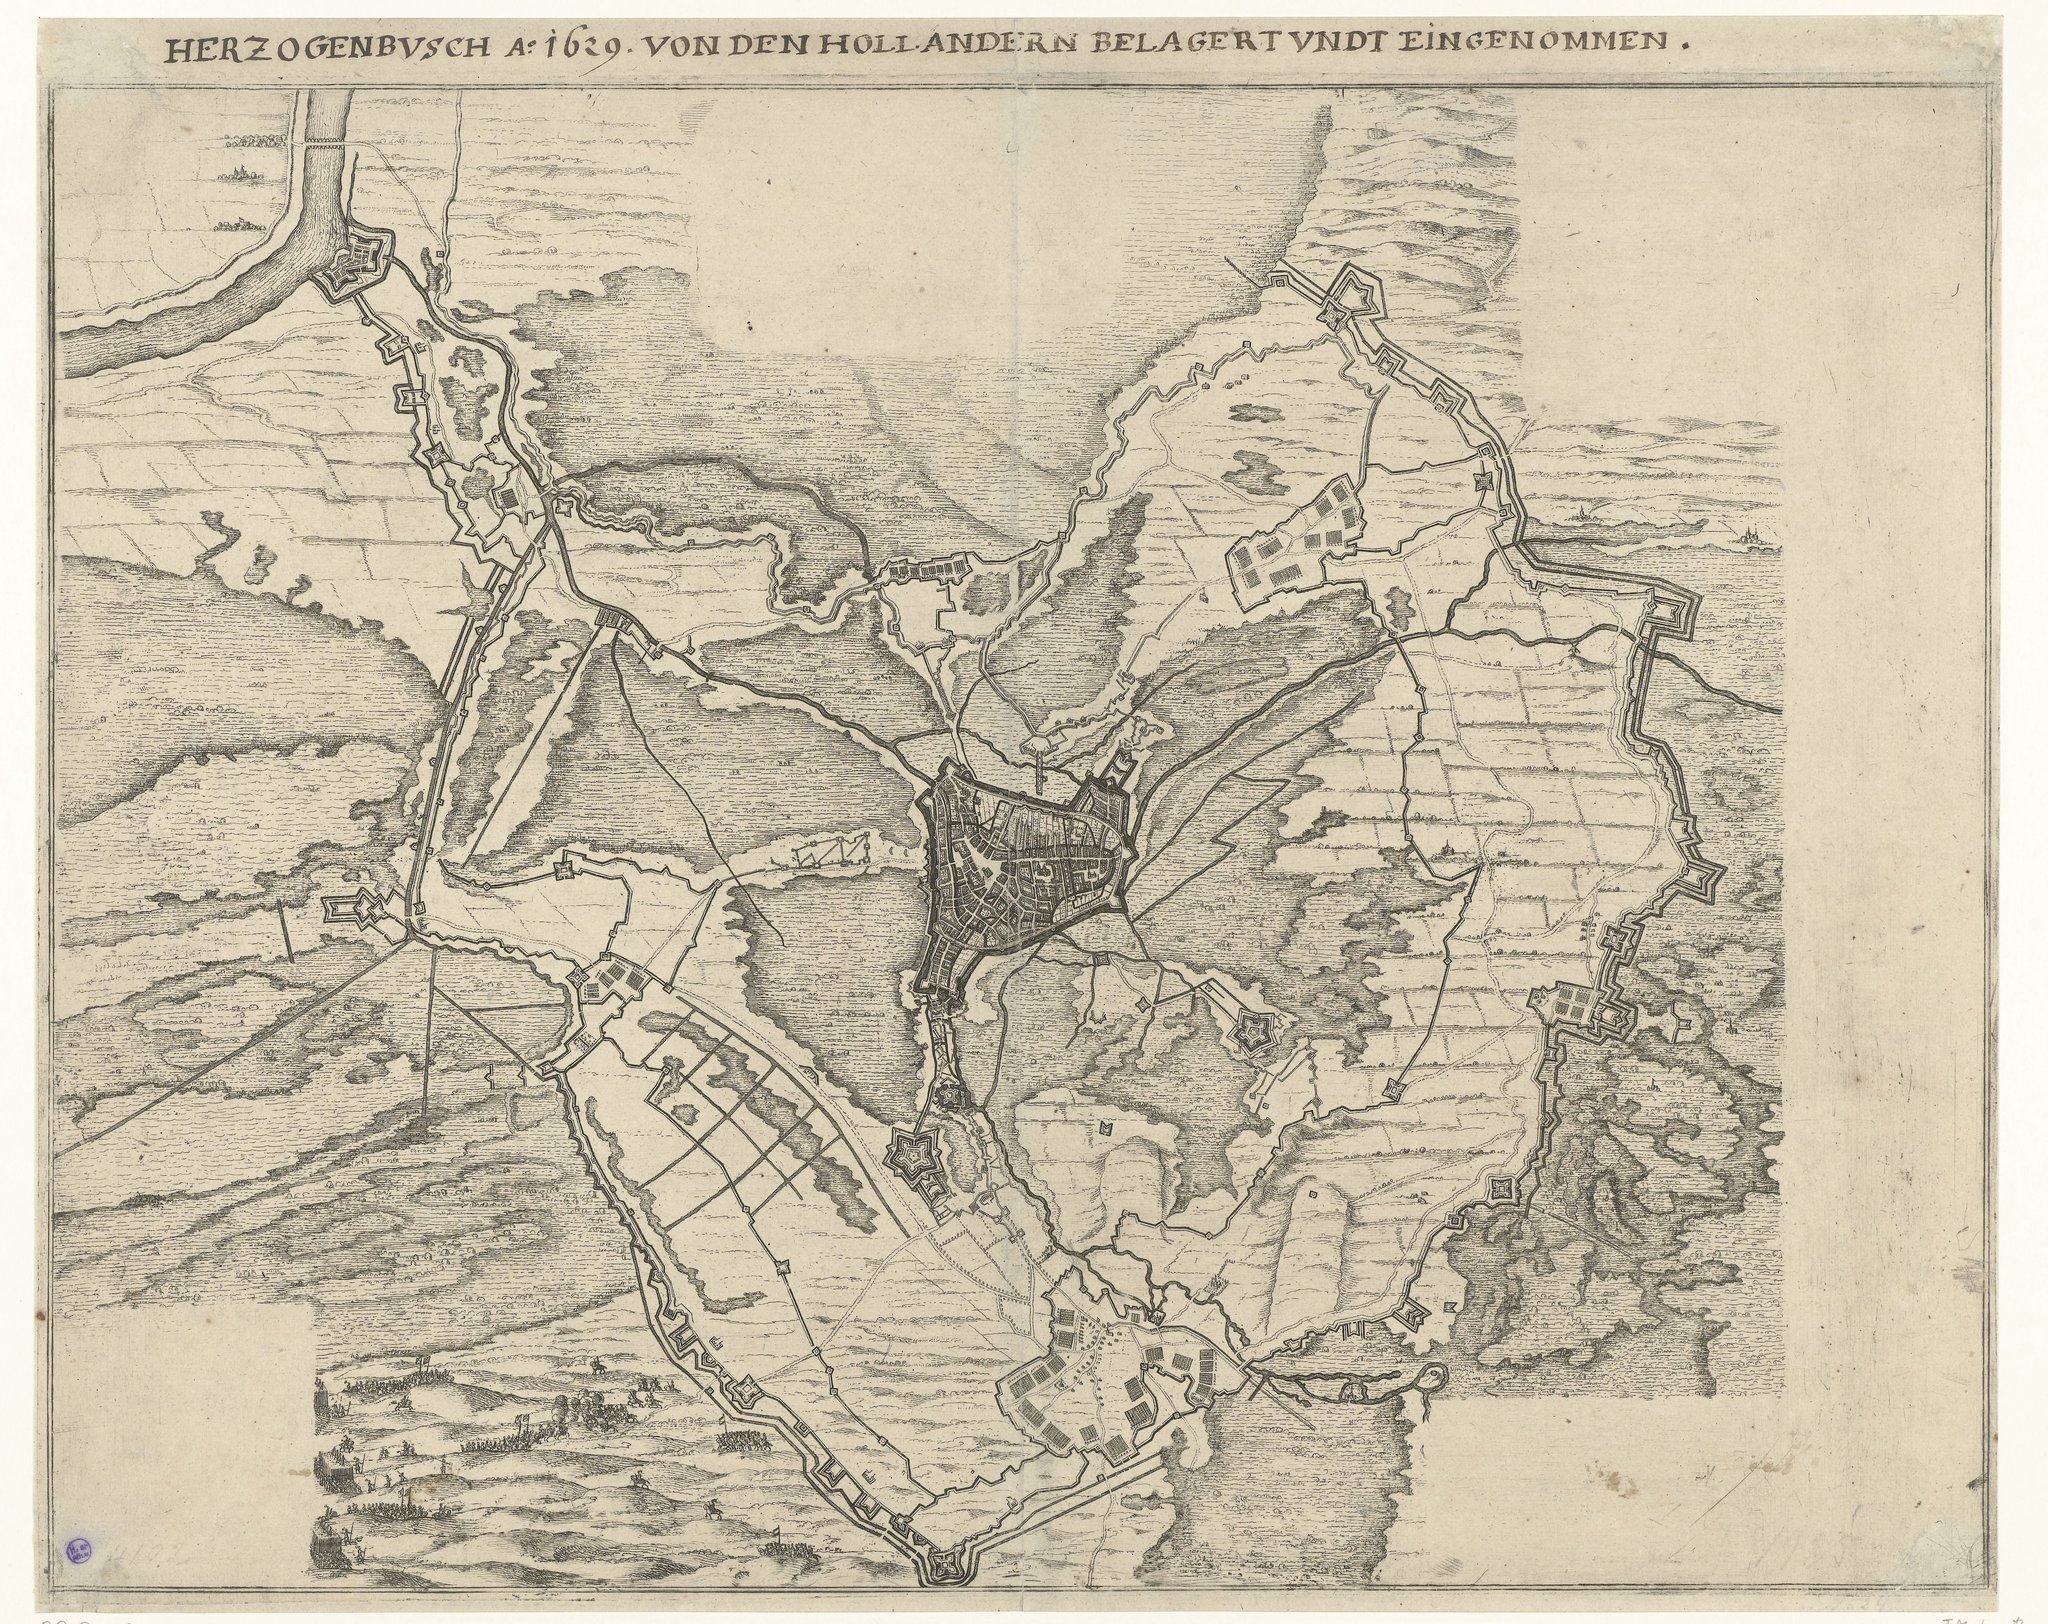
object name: map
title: Beleg van 's-Hertogenbosch, 1629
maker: Anonymous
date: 1649-1699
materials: paper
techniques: etching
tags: delft, the hague, frederick henry (prince of orange), maps of separate countries or regions, siege, position war, den bosch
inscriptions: collector's mark: Lugt 1337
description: Kaart van het beleg van Den Bosch door het Staatse leger onder Frederik Hendrik, van 1 mei tot 17 september 1629. Kaart van Den Bosch en het omliggende gebied met de omsingeling van de stad, linksboven Crèvecoeur aan de Maas, rechtsonder Vught. Met verschillende blanco delen bestemd voor cartouches of teksten.